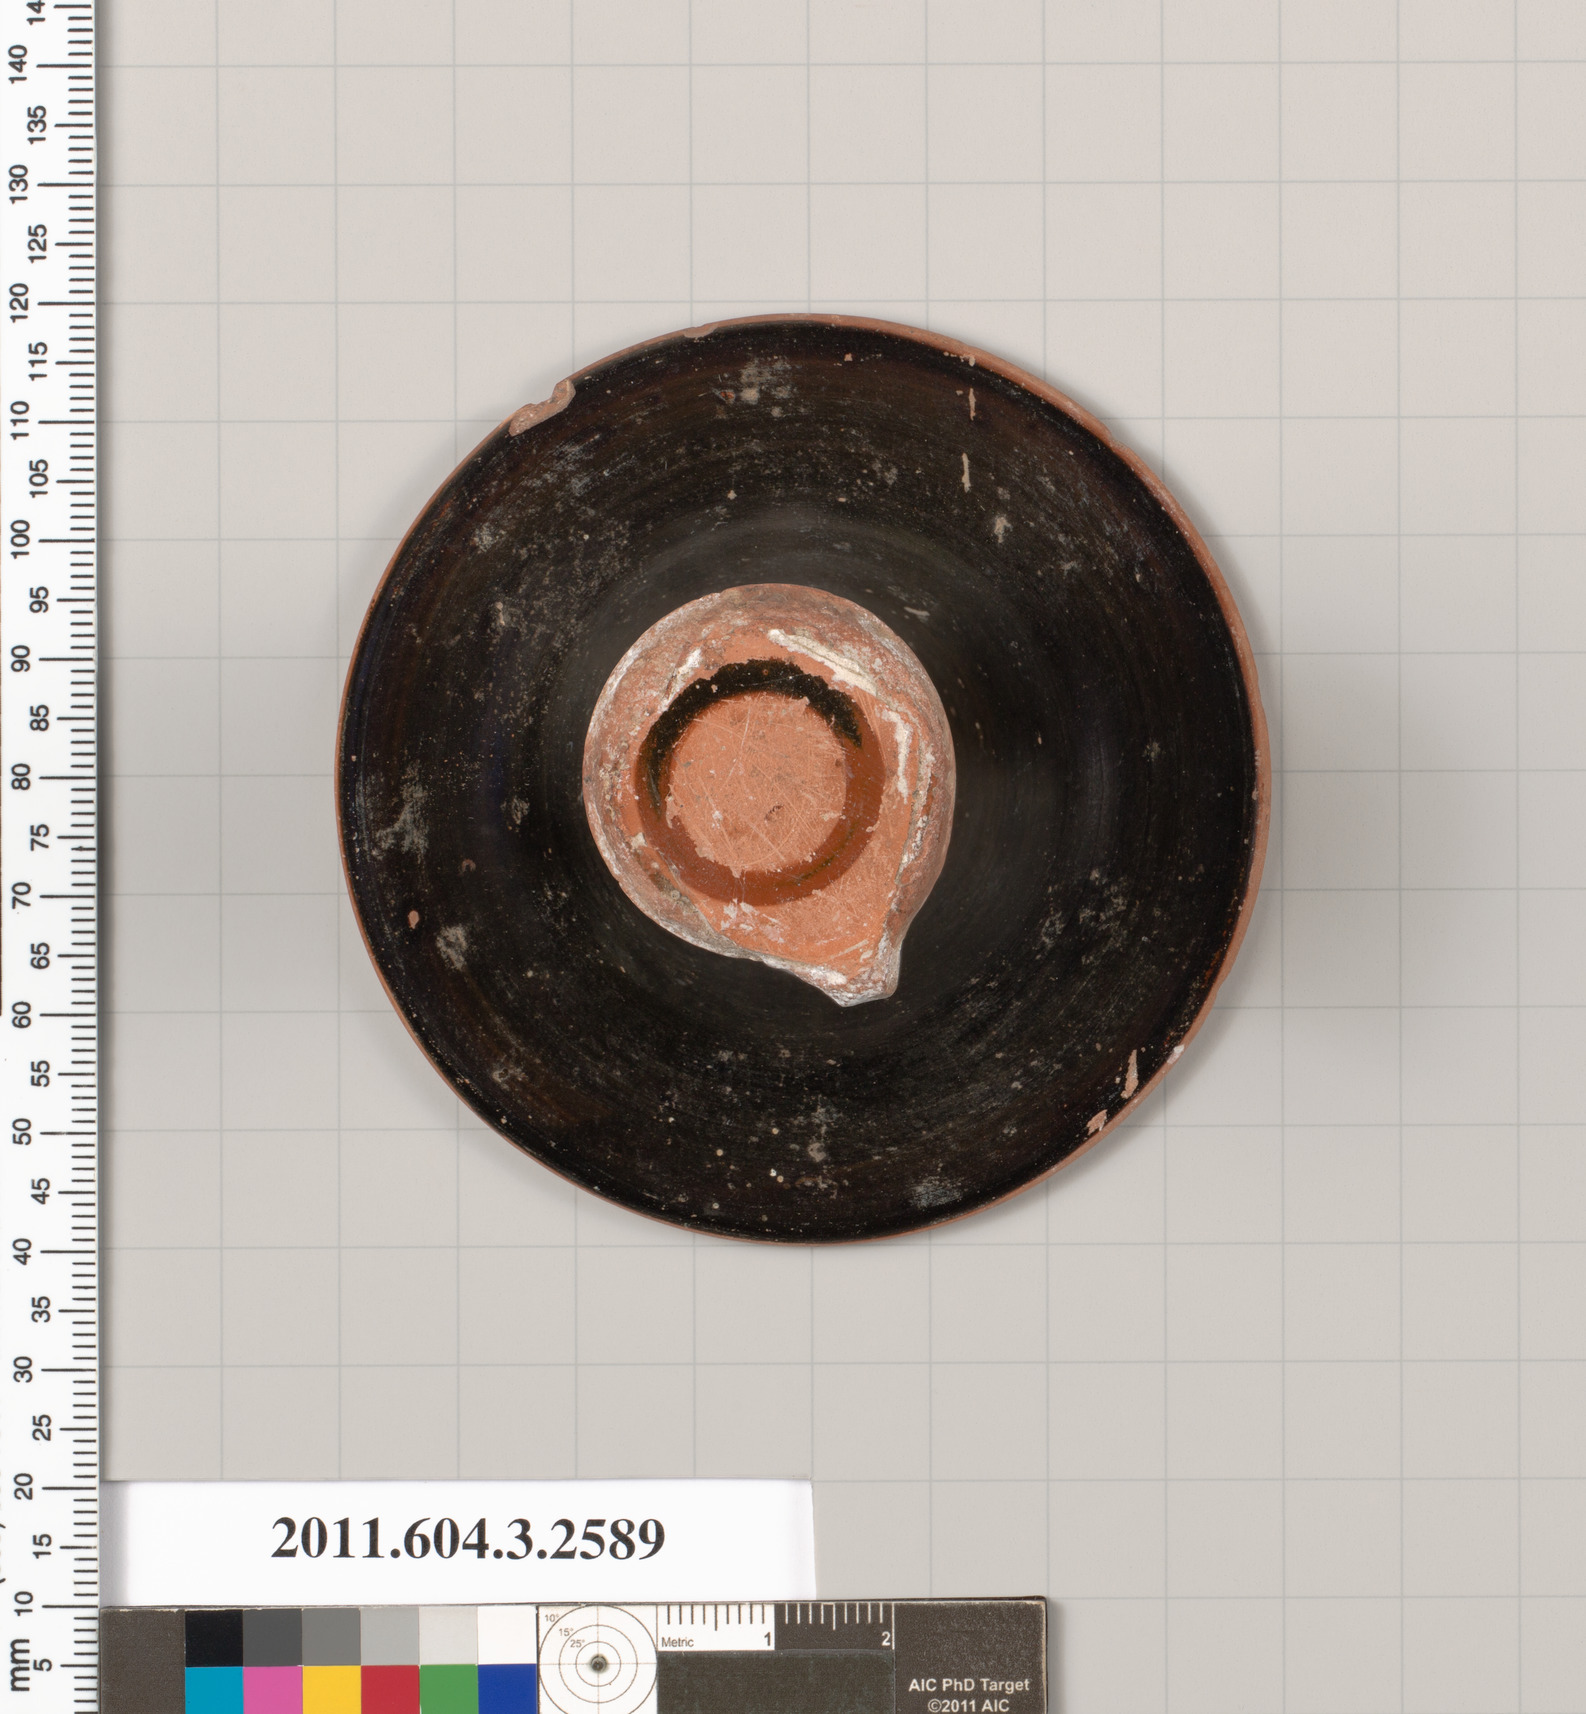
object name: kylix fragment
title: Terracotta fragment of a kylix (drinking cup)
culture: greek, attic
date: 575-525 BCE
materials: terracotta